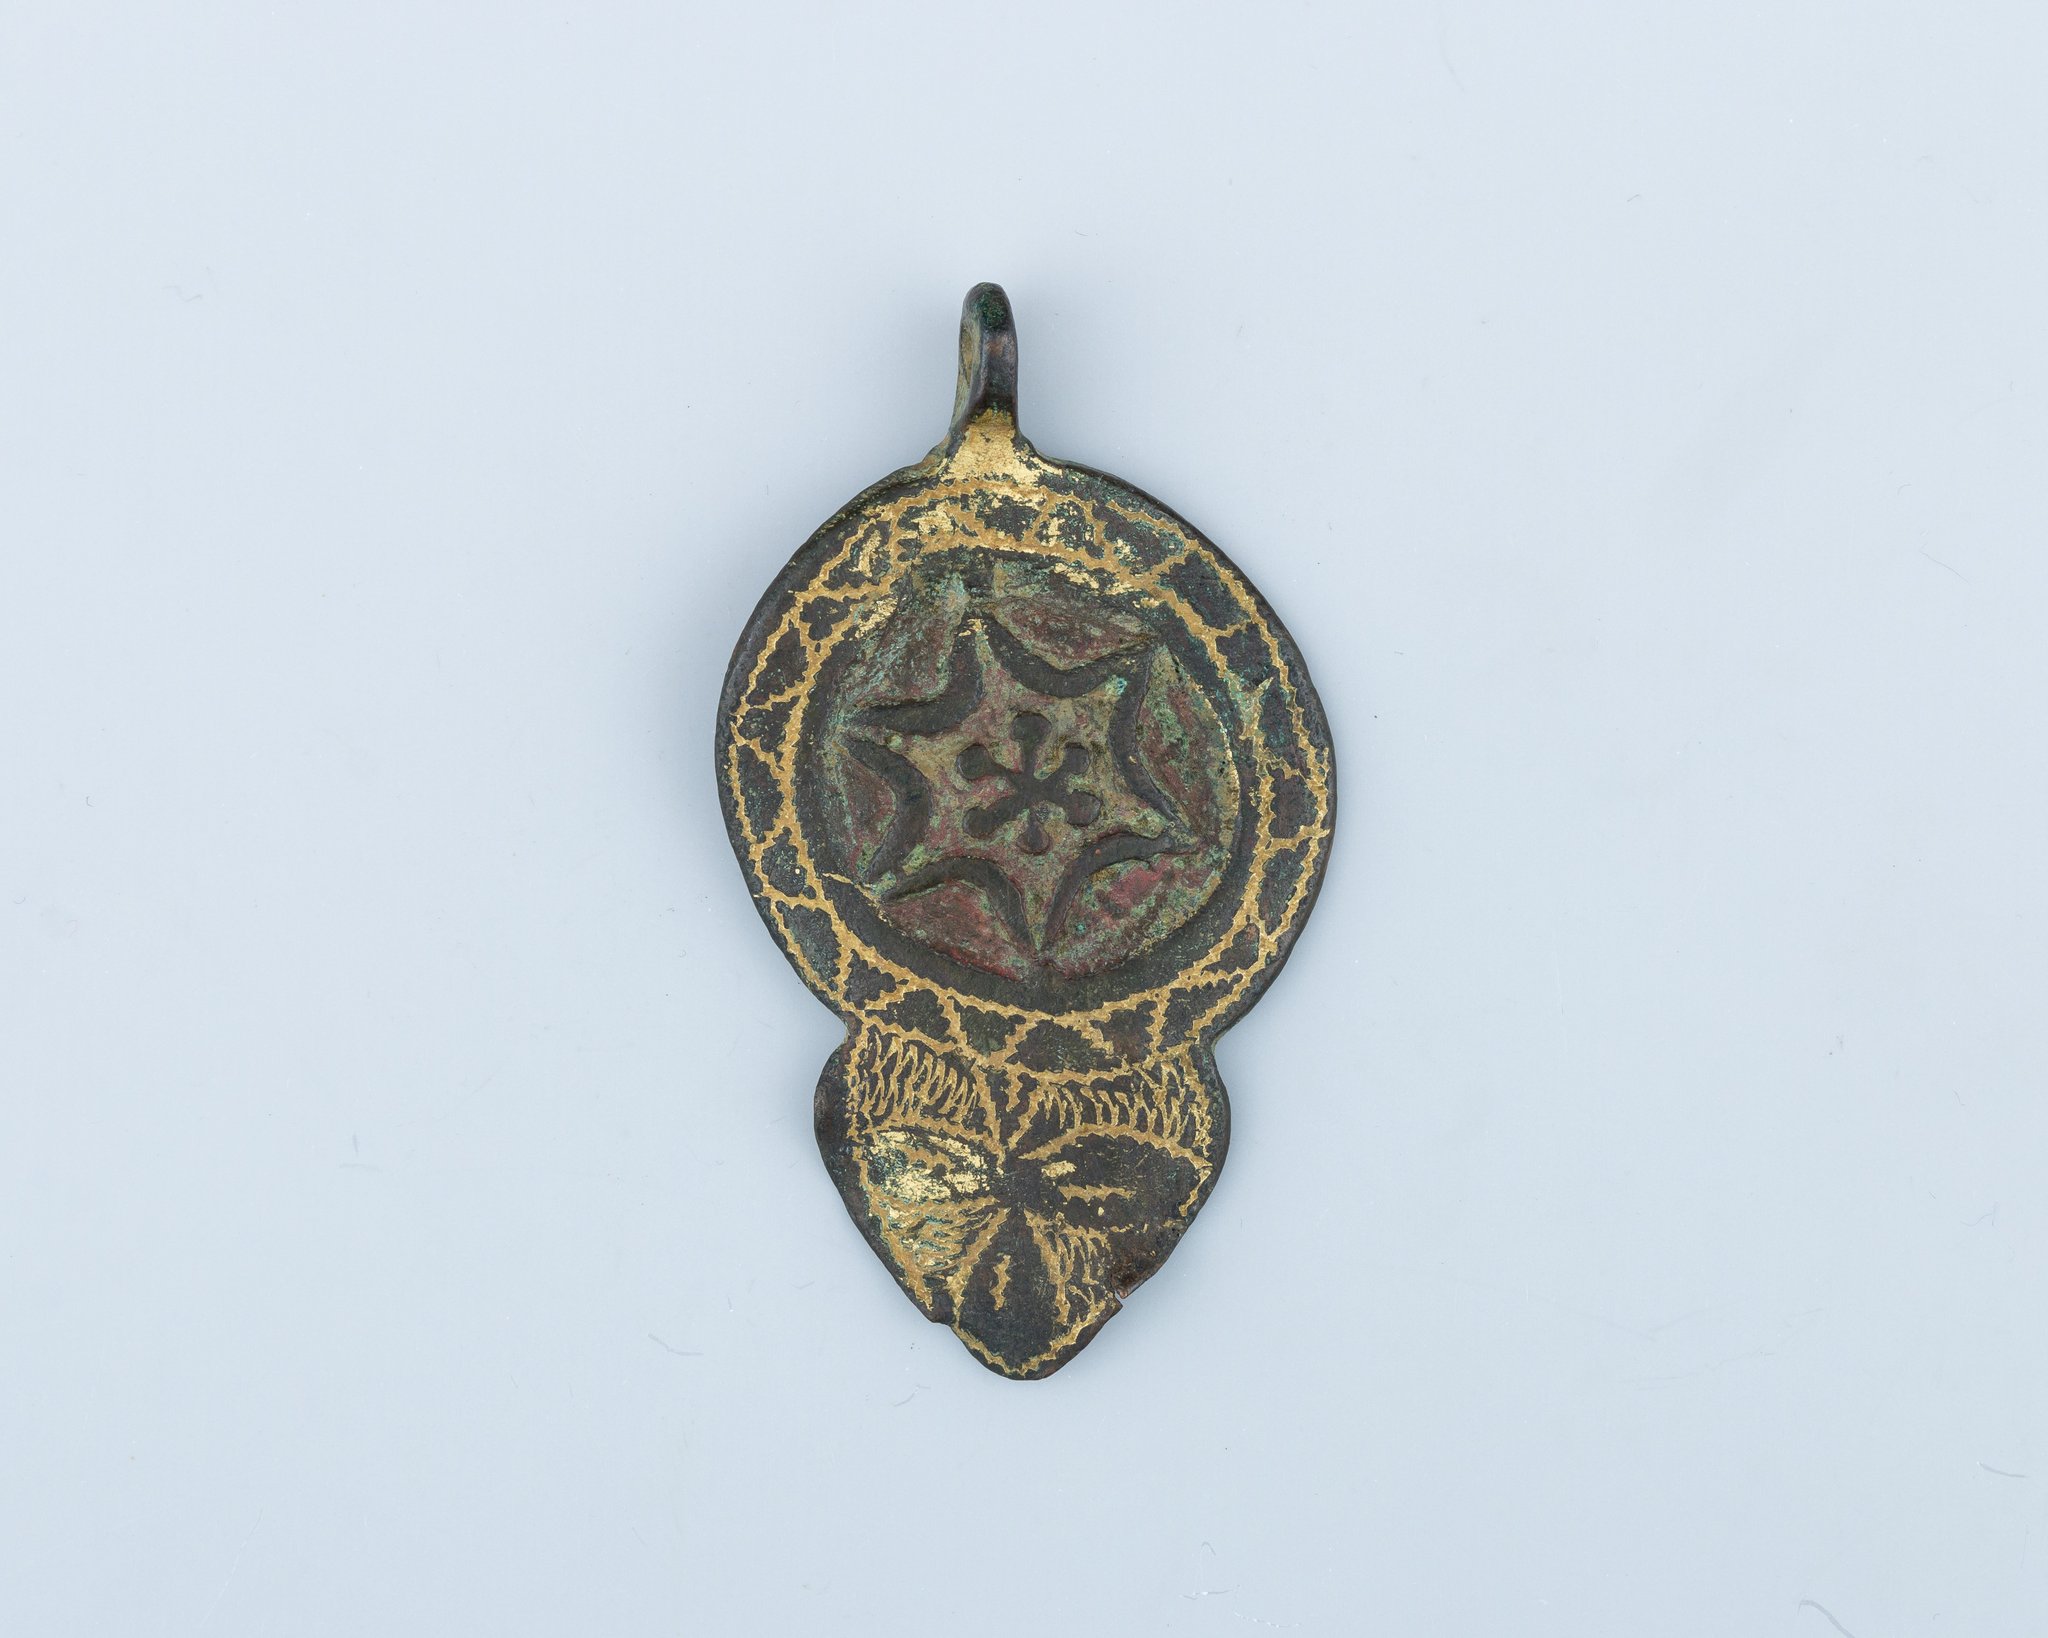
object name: ornament of horse trapping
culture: spanish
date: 1301-1400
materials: bronze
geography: spain